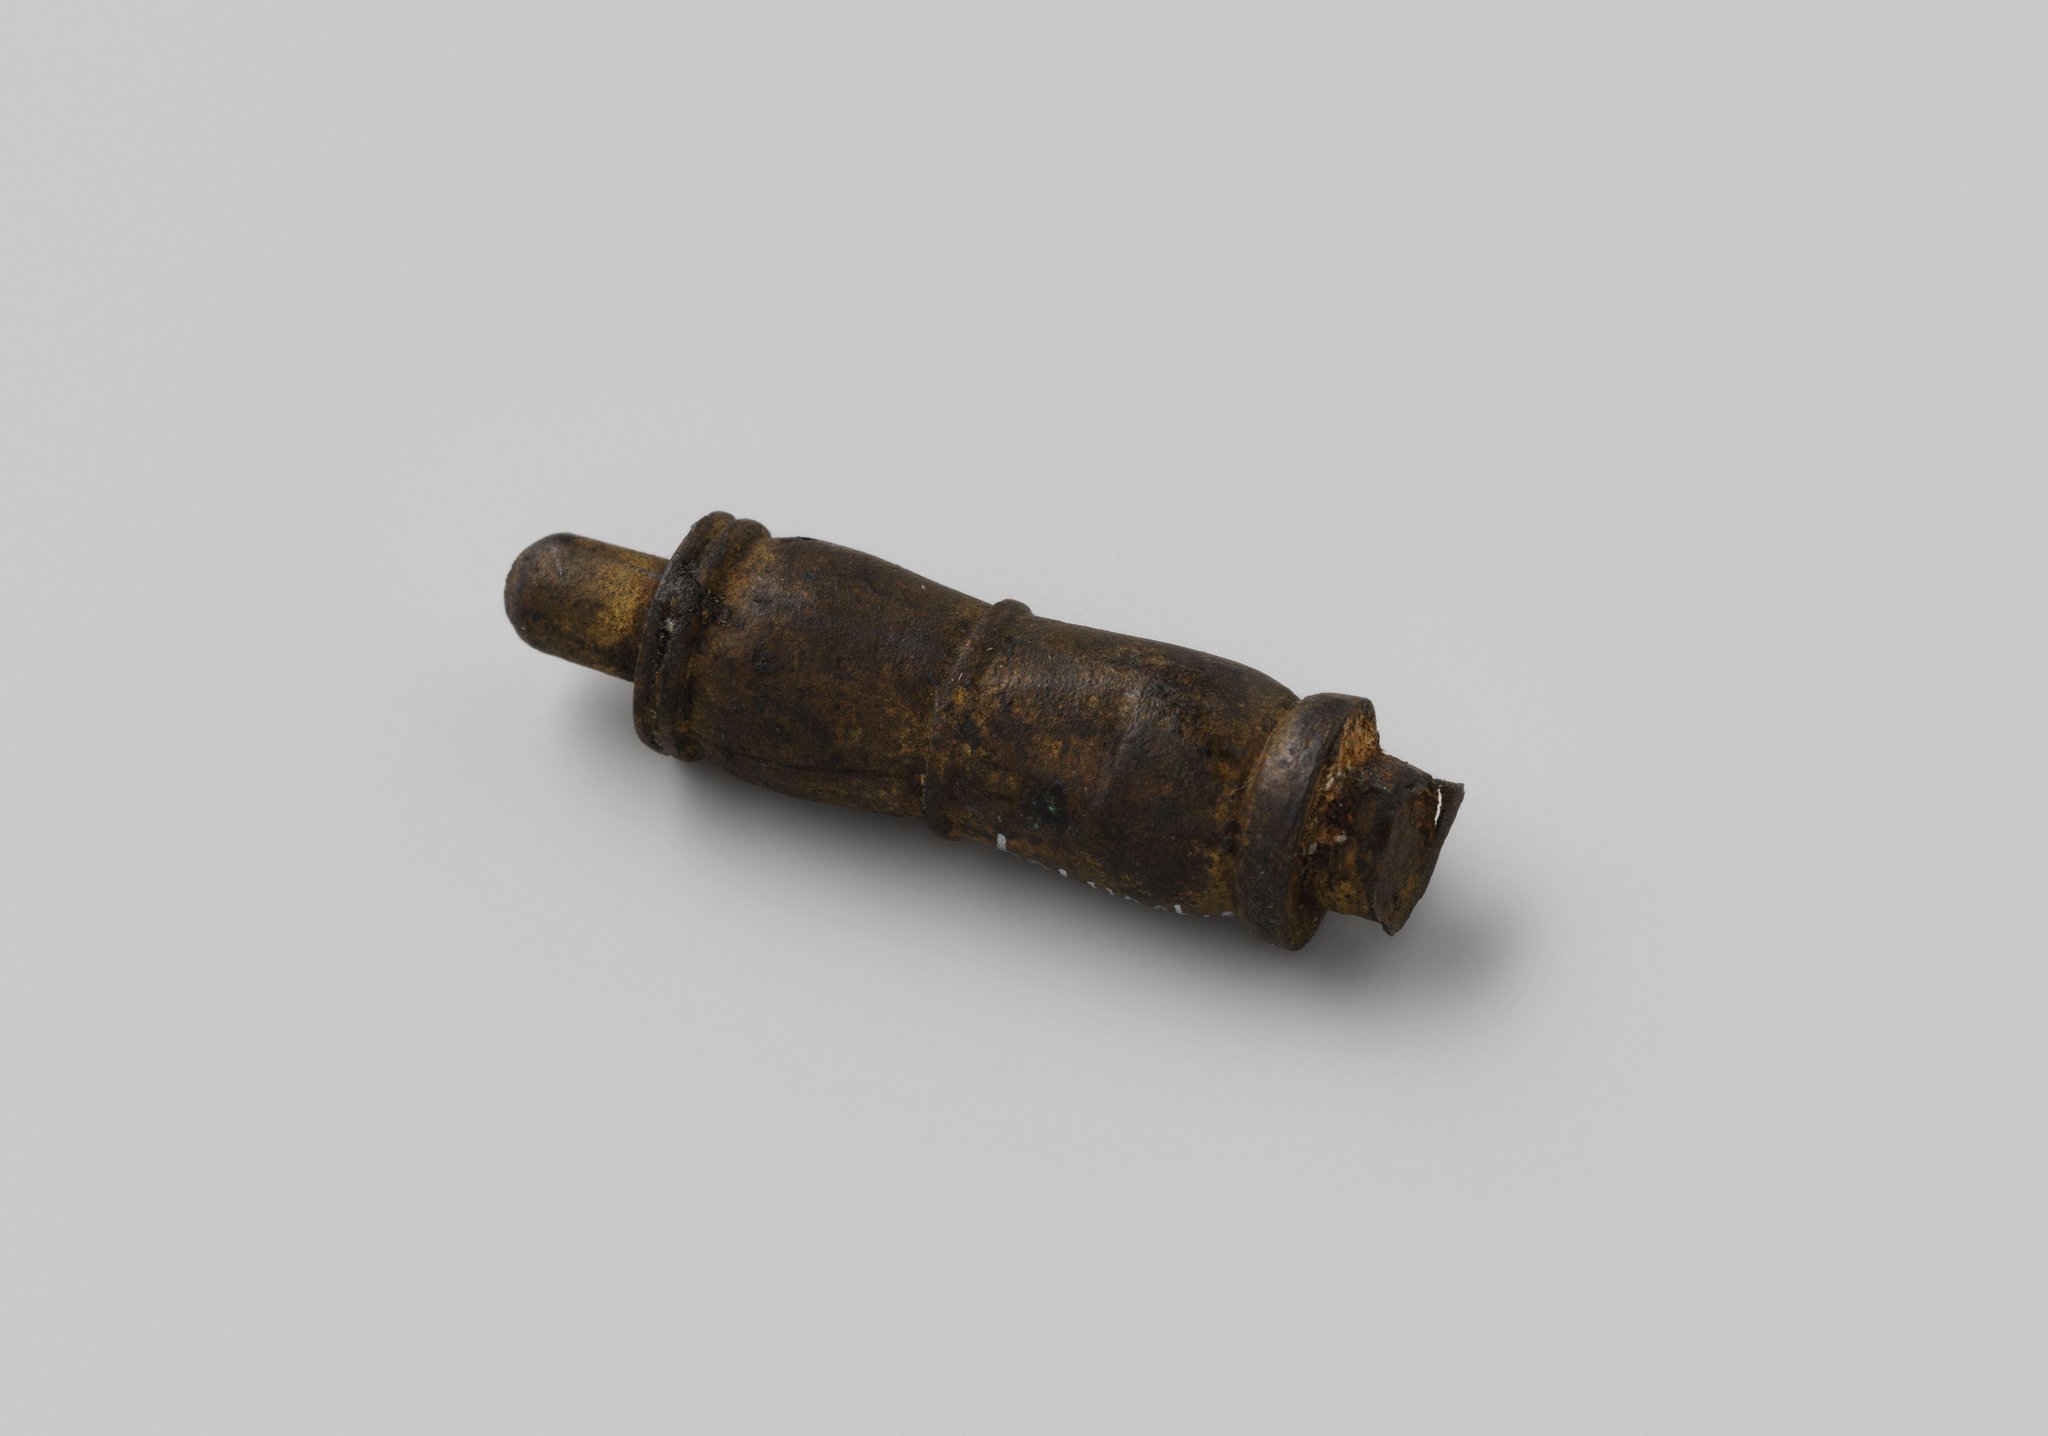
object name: helve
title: Fragment koperen steel uit het wrak van de Oost-Indiëvaarder Hollandia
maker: Anonymous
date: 1700-1743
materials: copper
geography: netherlands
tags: verenigde oostindische compagnie, hollandia (schip), annet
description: Varied parts or fragments, shafts; cylindrical, moulded with ring-shaped bands, flat top with short spindle, flat base with flattened tenon.